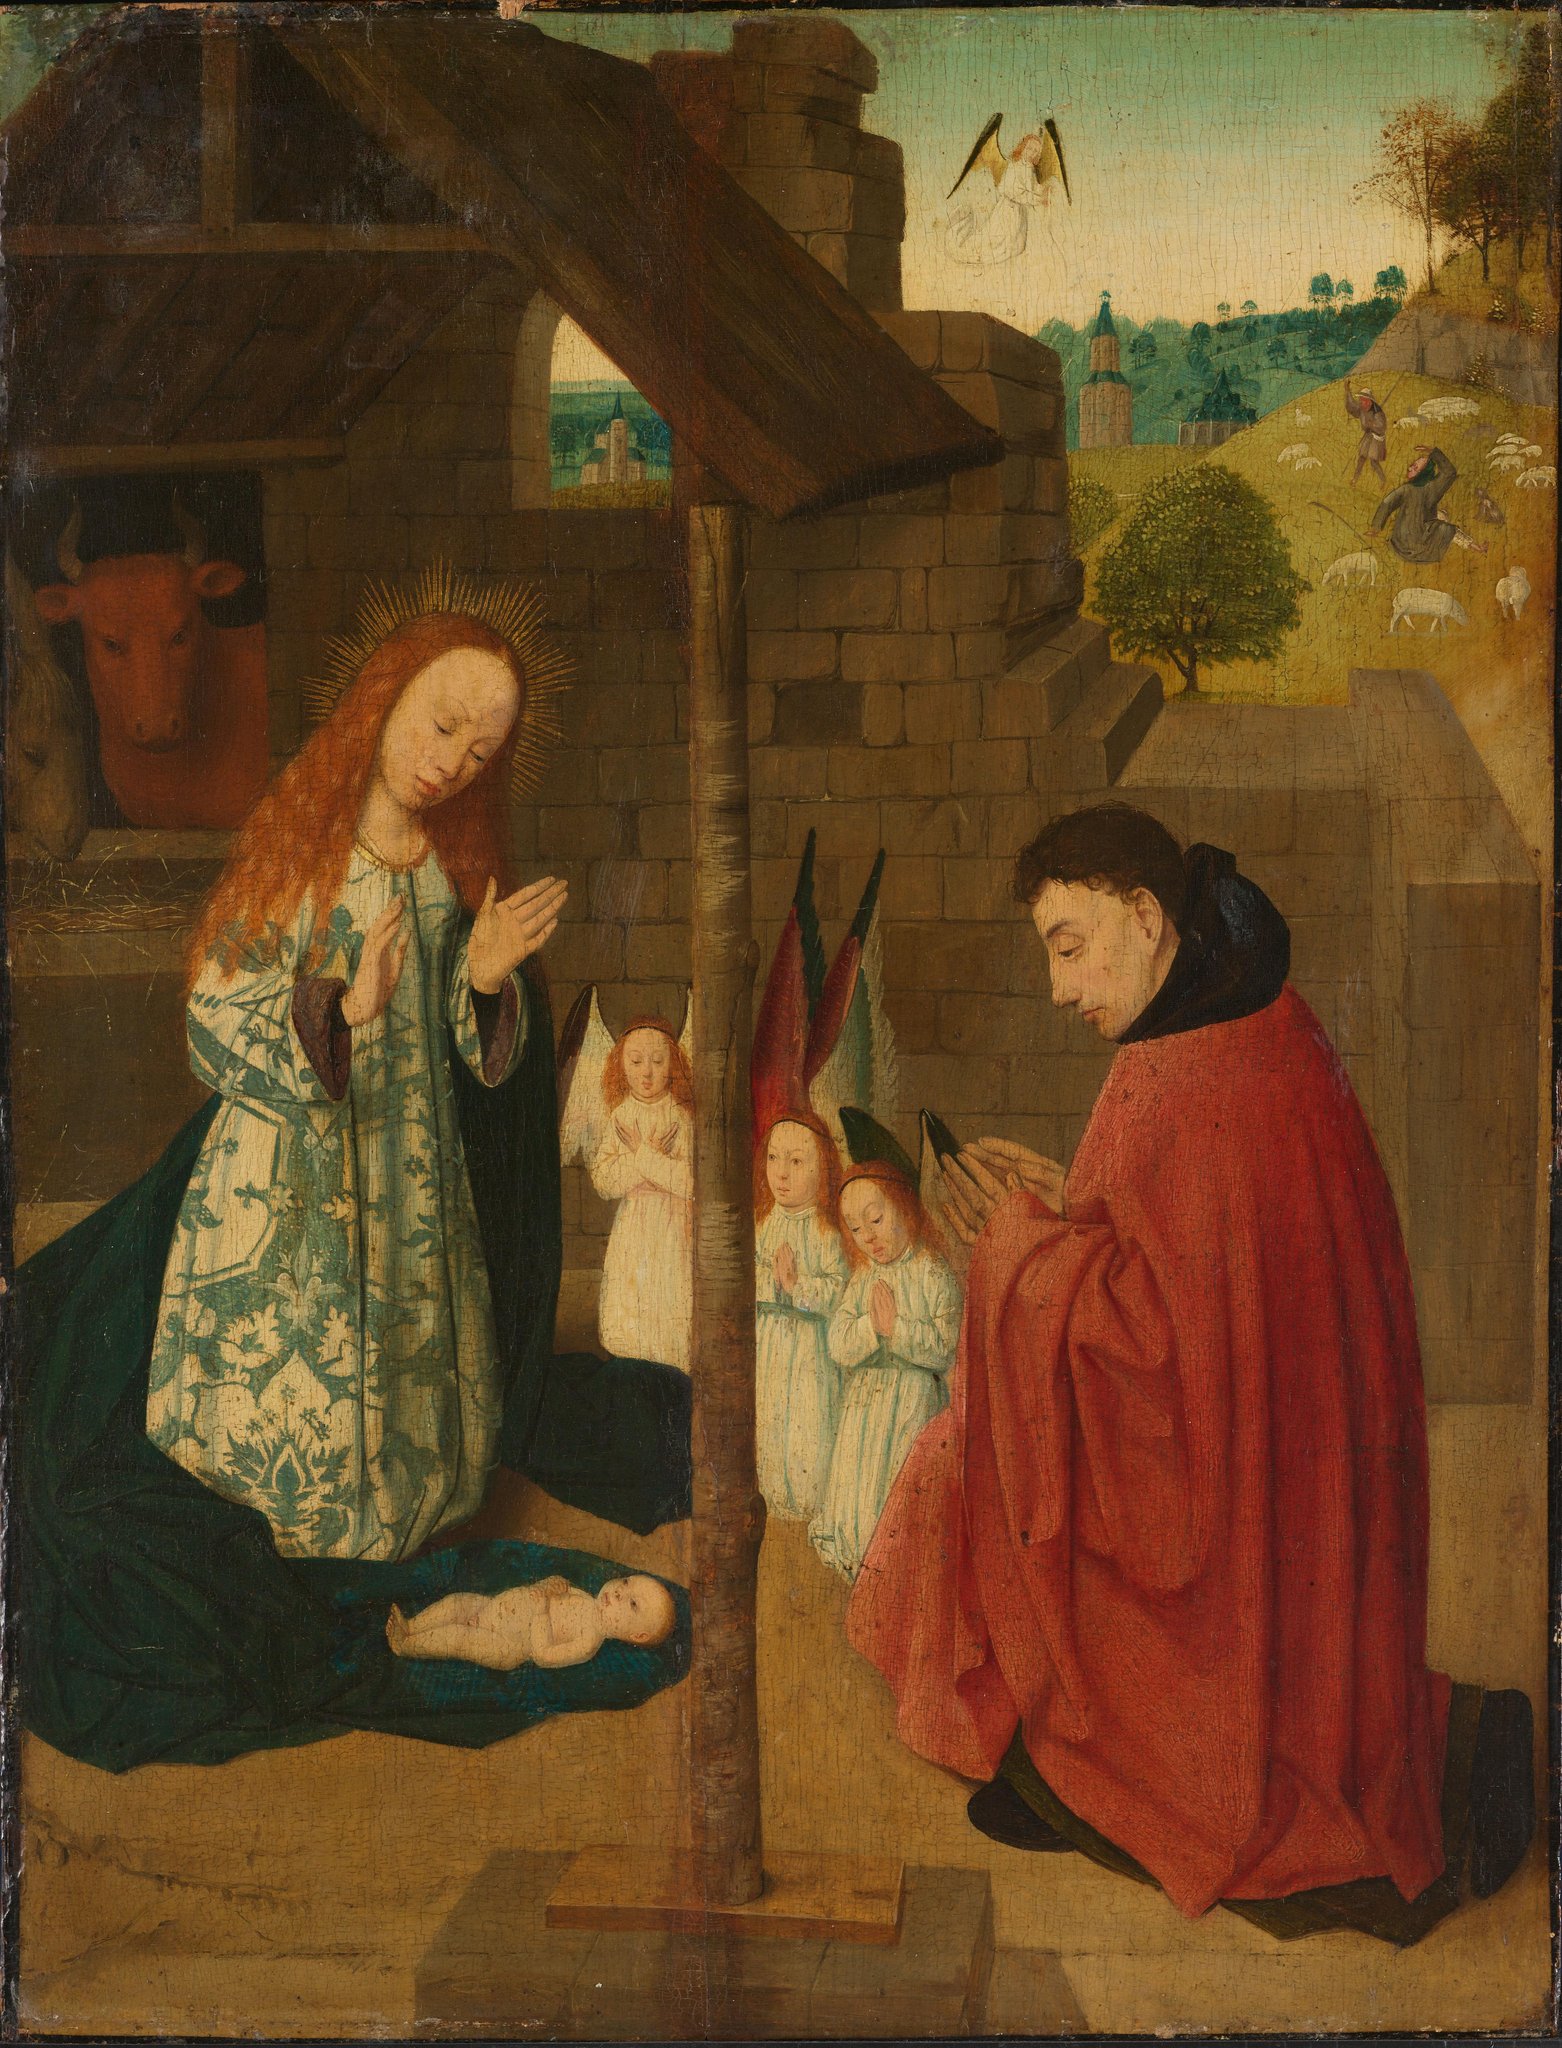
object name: painting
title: Birth of Christ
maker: master of the brunswick diptych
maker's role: painter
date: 1490-1500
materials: oil, panel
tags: adoration of the christ-child by mary and joseph (+ angel(s))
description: De geboorte van Christus. Maria, drie engelen en een stichter (of Jozef?) knielen in aanbidding bij het Christuskind dat op de mantel van Maria op de grond van de stal ligt. In het landschap op de achtergrond de verkondiging aan de herders.